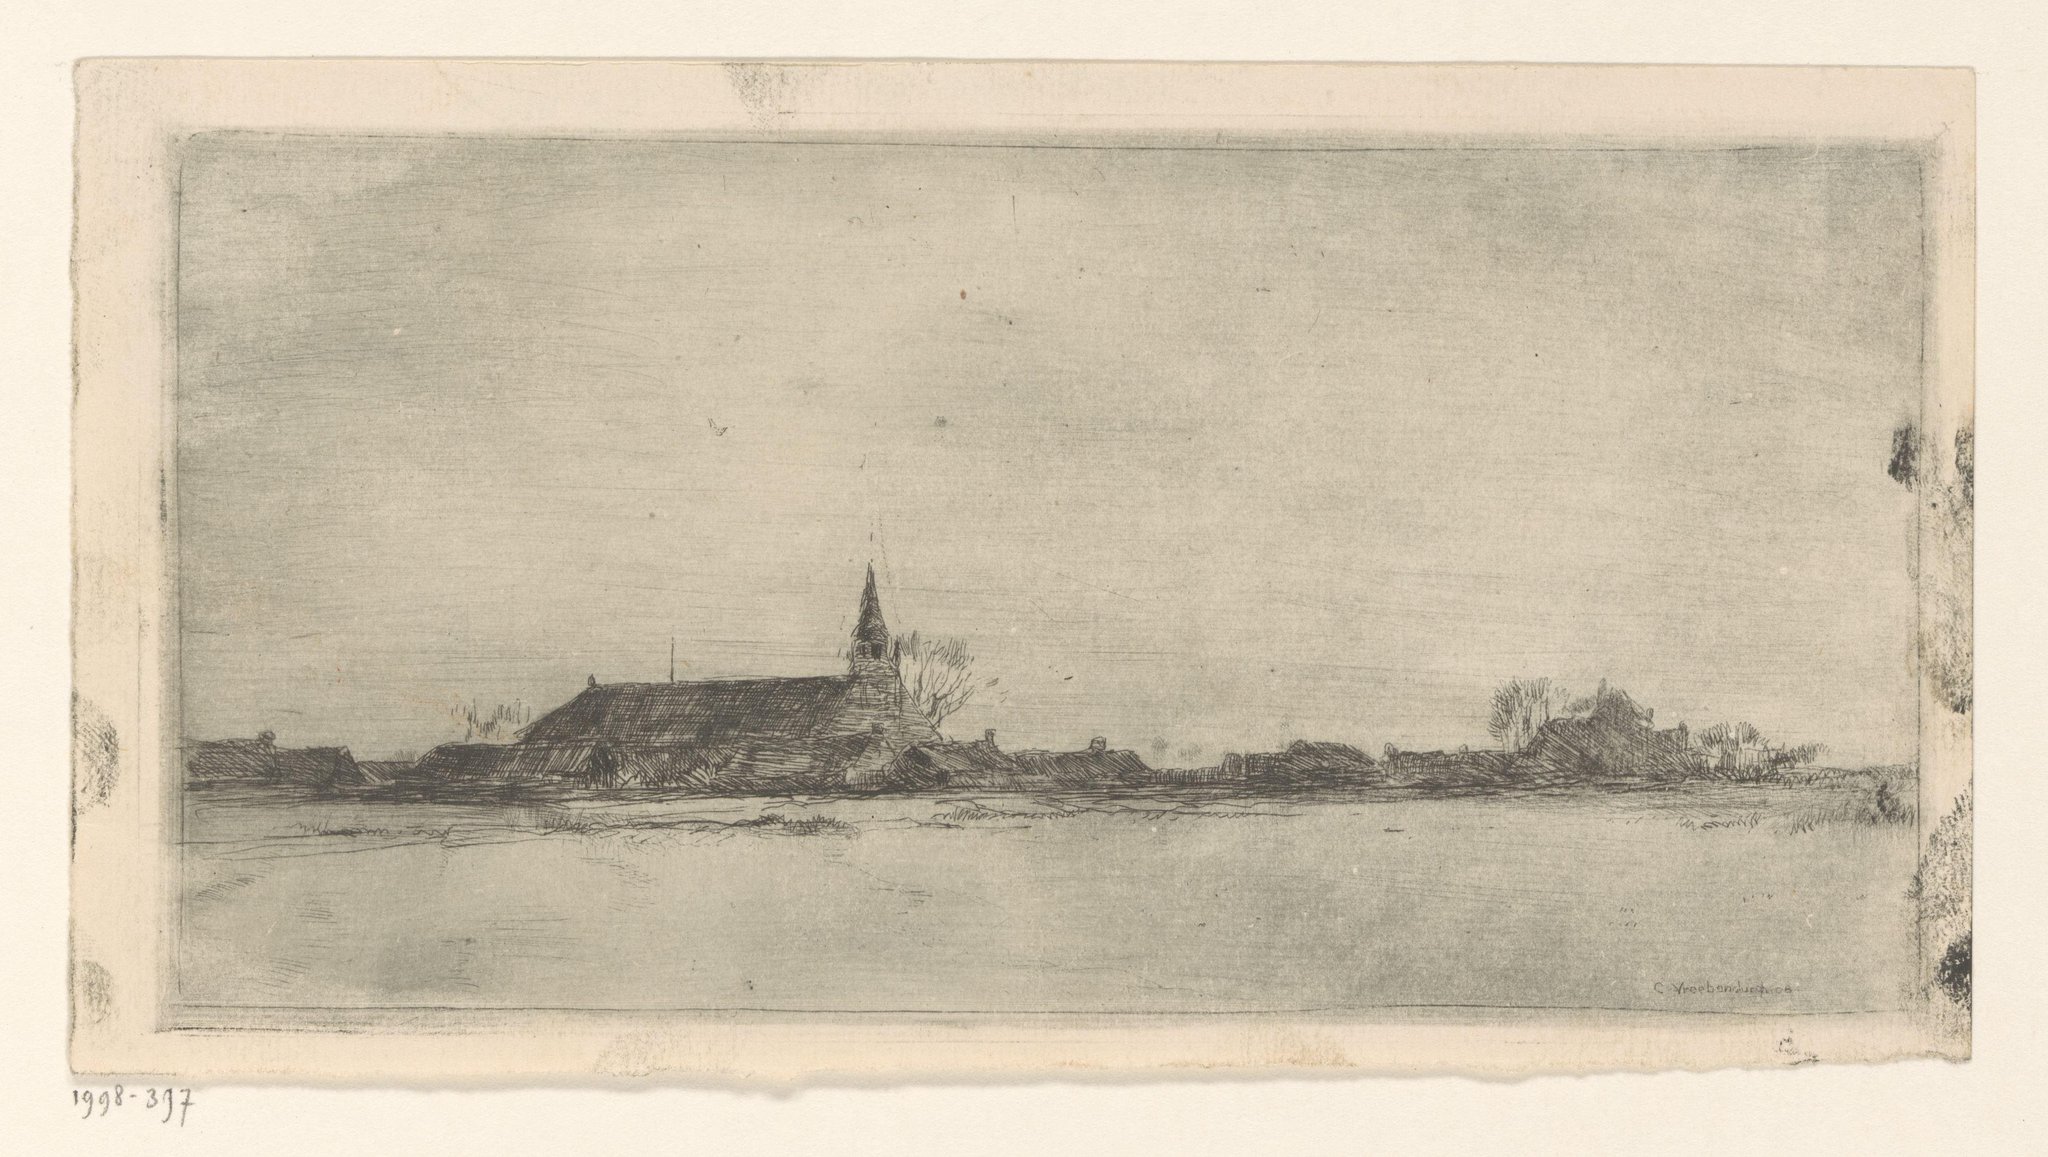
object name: print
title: Dorpsgezicht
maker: cornelis vreedenburgh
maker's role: draughtsman, print maker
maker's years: 1880-1946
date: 1908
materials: paper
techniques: drypoint, etching, intaglio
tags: prospect of village, silhouette of village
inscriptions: collector's mark: Lugt 2228, collector's mark: Lugt 2760